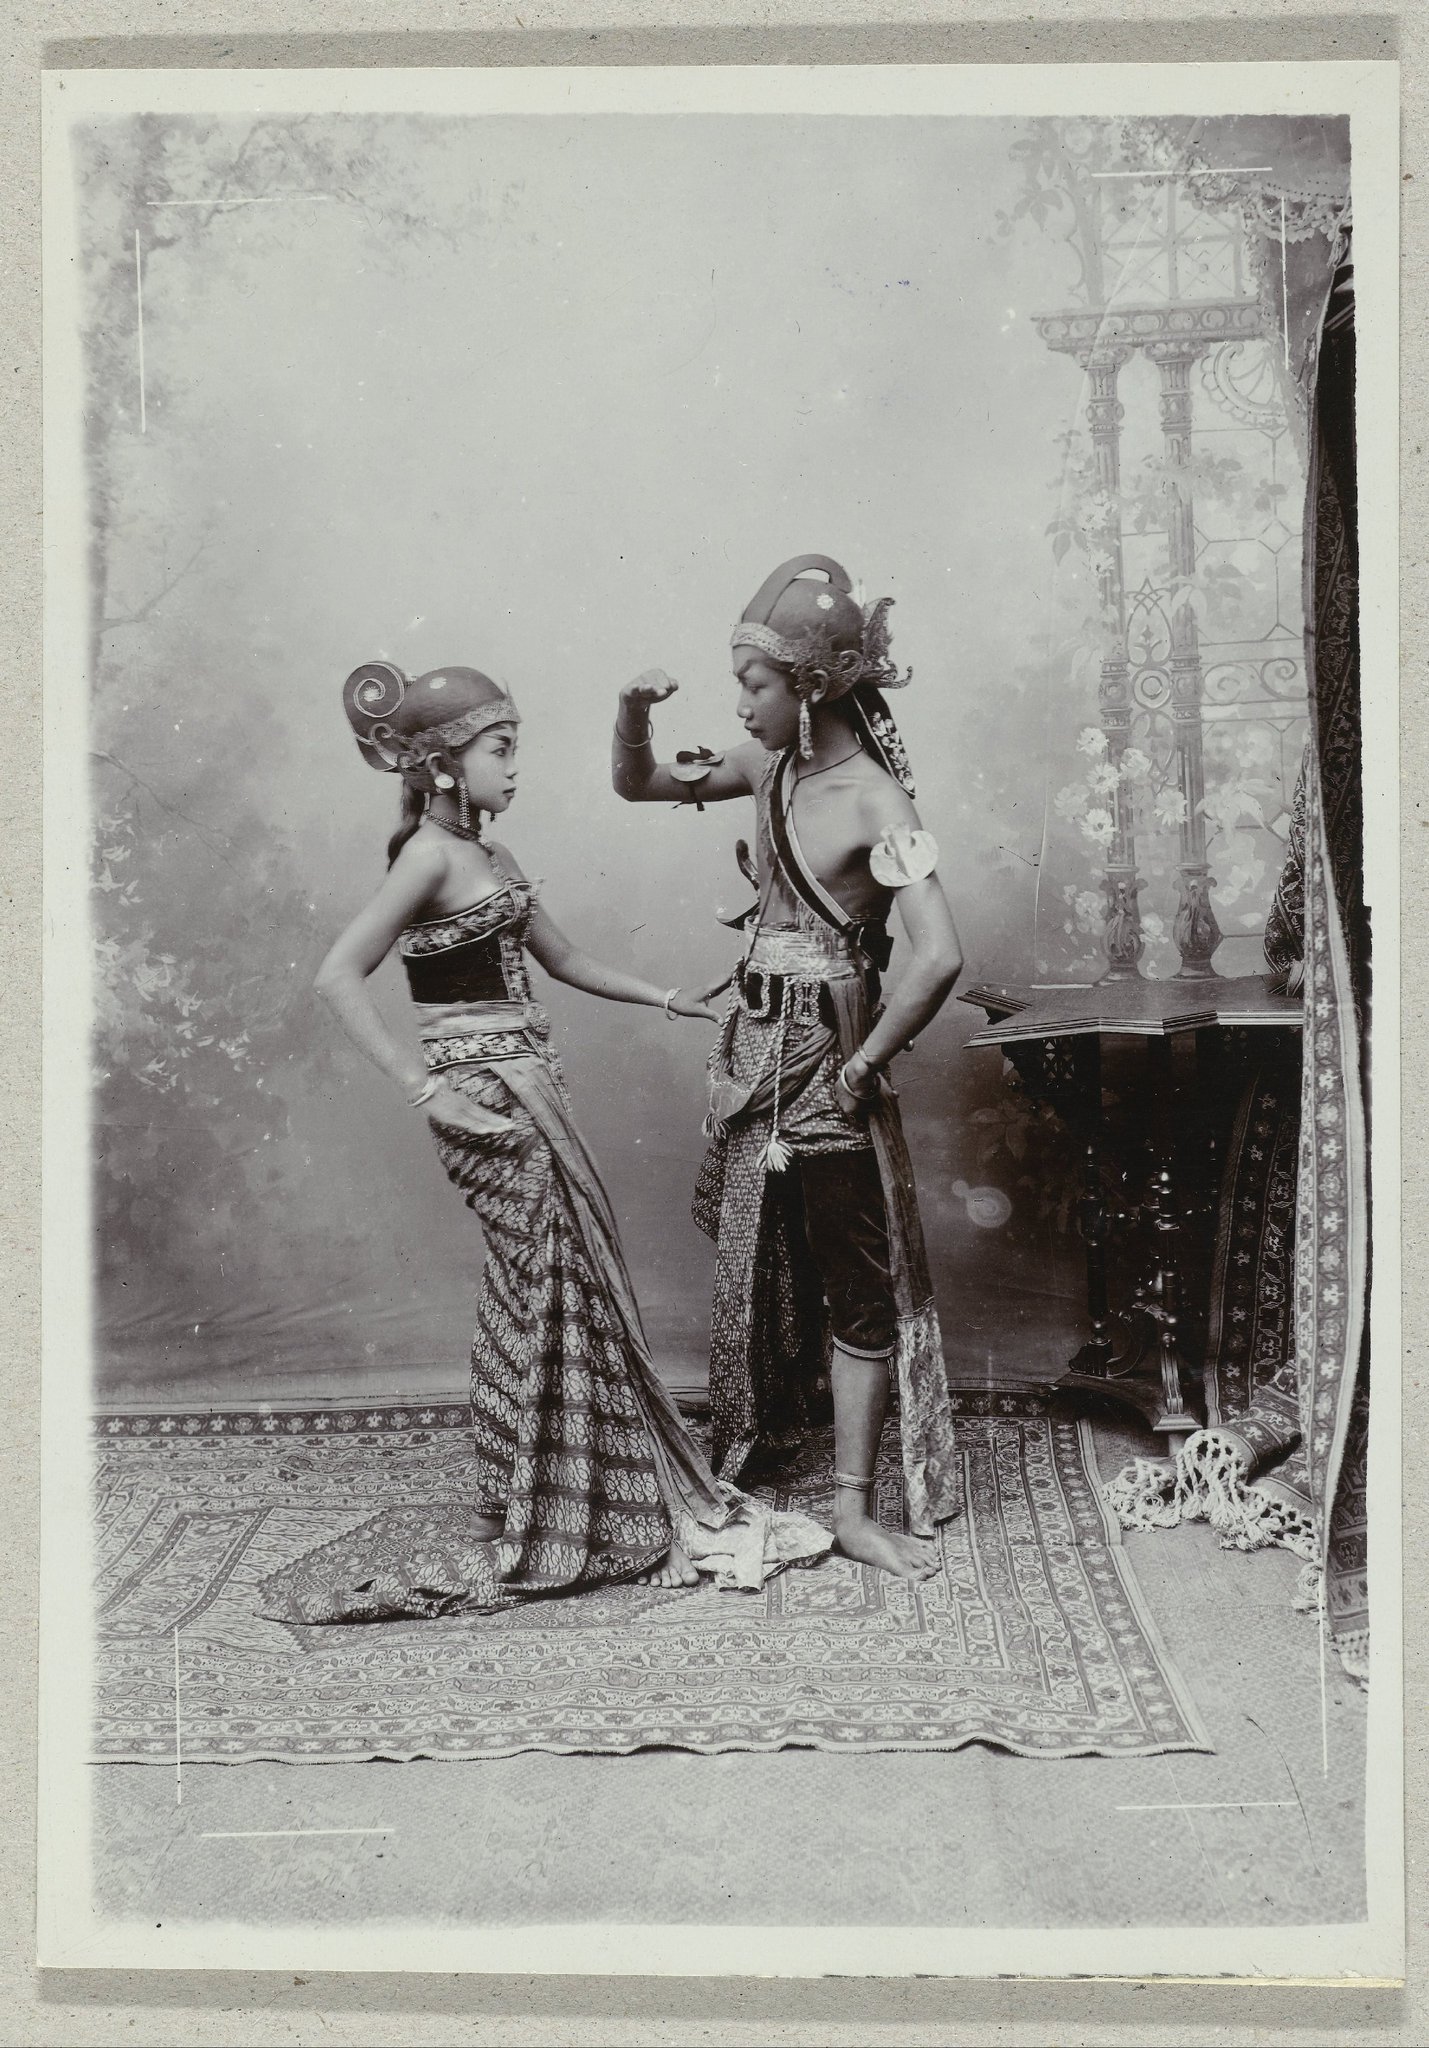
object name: photograph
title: Studio portret van twee Javaanse dansers in traditionele kleding en make up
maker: kassian céphas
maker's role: fotograaf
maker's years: 1845-1912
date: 1870-1912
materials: cardboard, paper, photographic support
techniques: albumen print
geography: java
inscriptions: name: ‘Met de beste wenschen voor 1916 van de familie Boekhout’